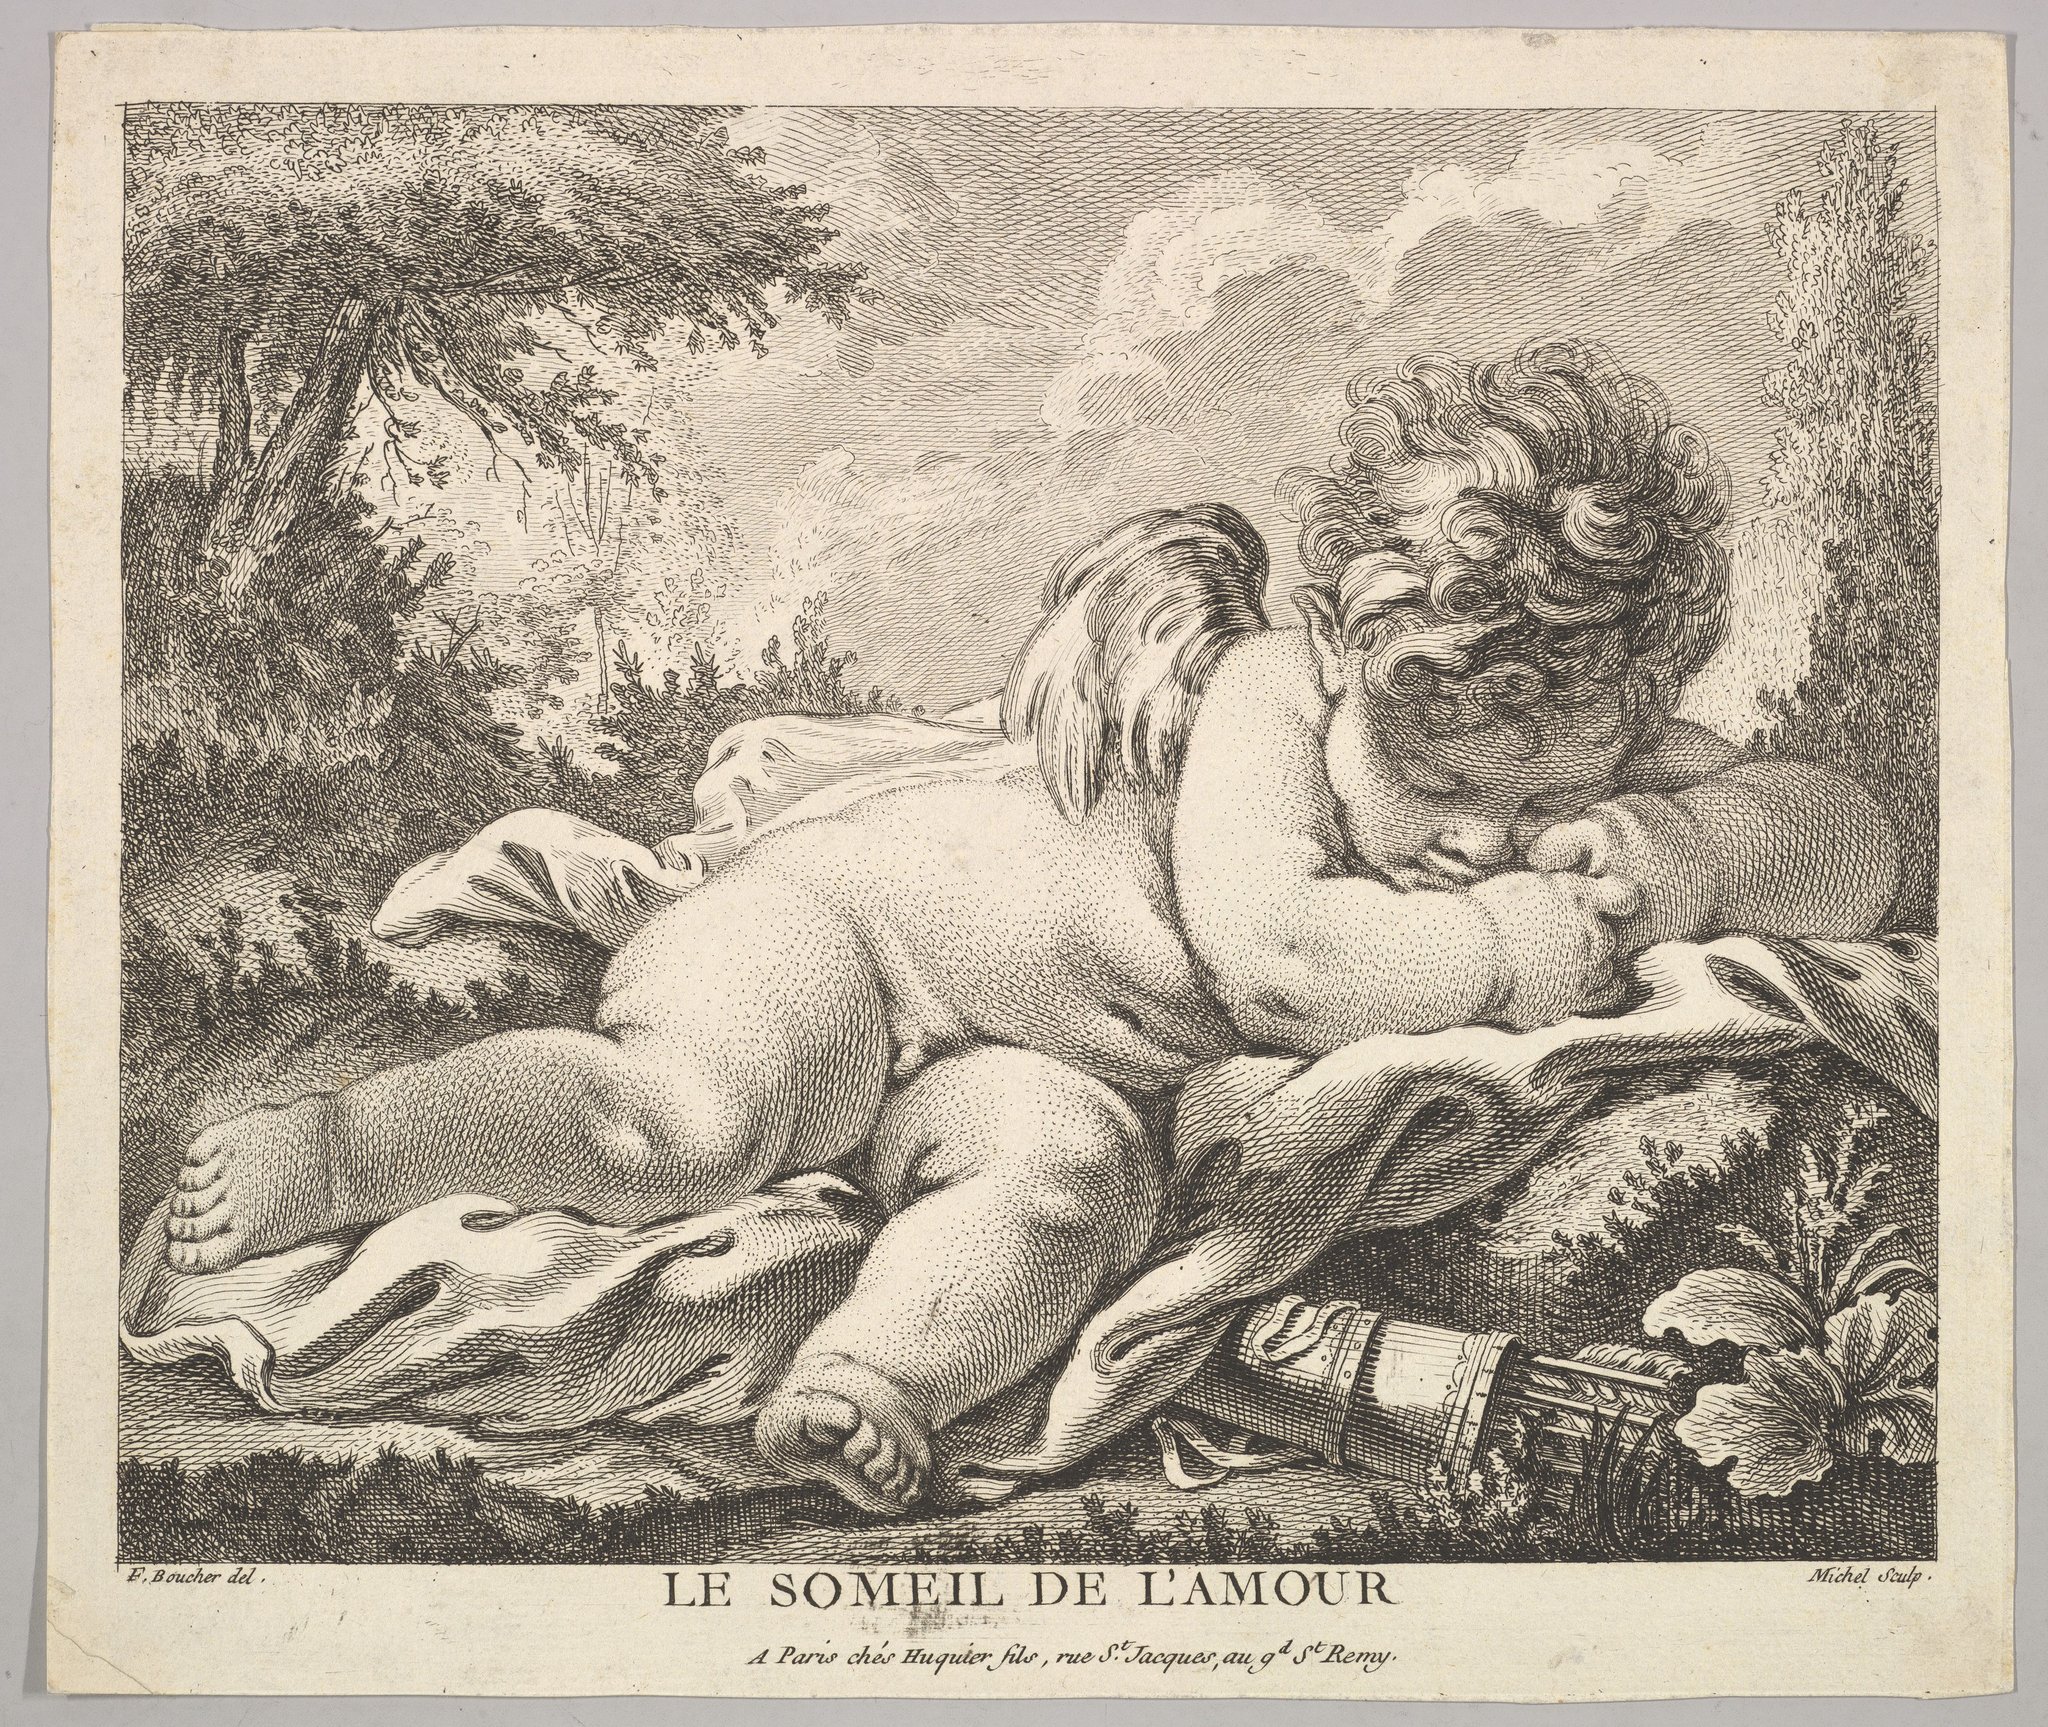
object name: print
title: The Sleep of Cupid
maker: jean-baptiste michel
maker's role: artist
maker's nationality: french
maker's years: 1748-1804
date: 1748-1804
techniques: engraving, etching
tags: sleeping,cupid